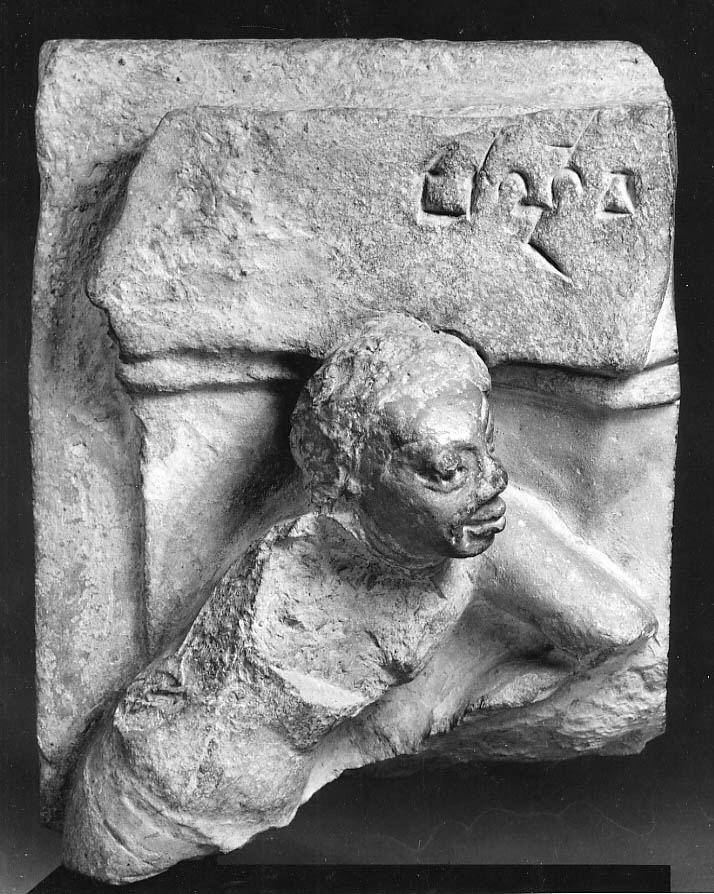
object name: plaque fragment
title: Fragment of a Plaque with a Figure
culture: indian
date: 401-500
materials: terracotta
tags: gupta